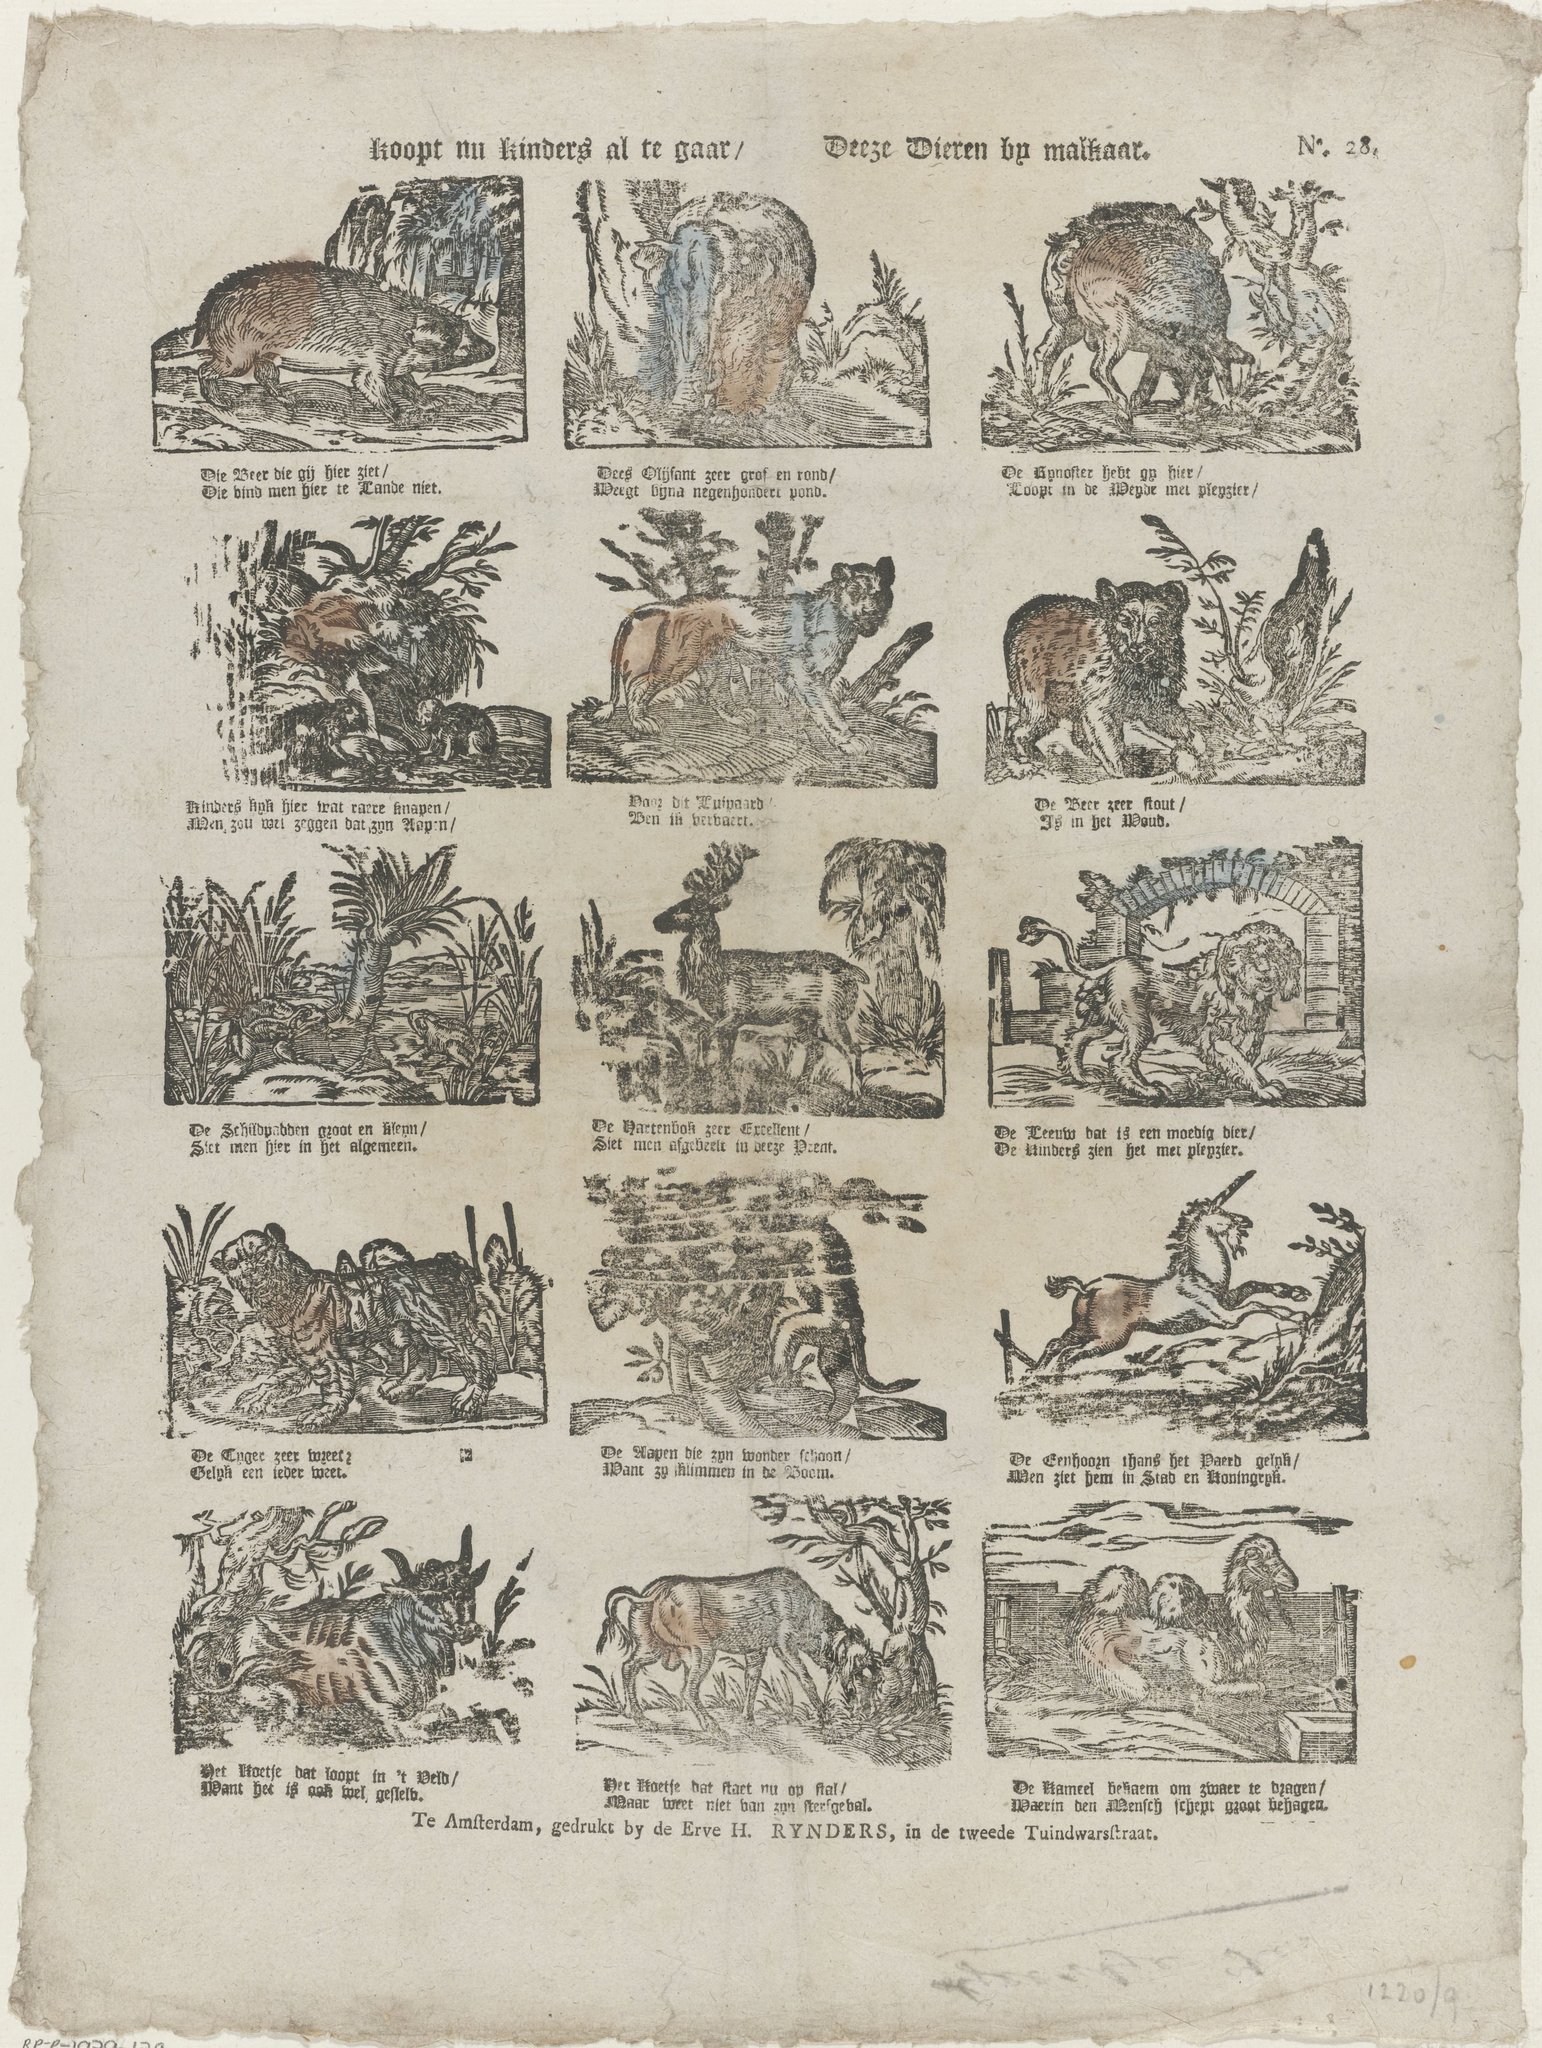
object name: print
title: Koopt nu kinders al te gaar / Deeze dieren by malkaar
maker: Anonymous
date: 1831-1854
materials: paper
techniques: colour, letterpress printing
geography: amsterdam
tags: beasts of prey, predatory animals: tiger, beasts of prey, predatory animals: leopard, unicorn, animals, beasts of prey, predatory animals: bear, beasts of prey, predatory animals: lion, trunked animals: elephant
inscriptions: collector's mark: Lugt 2228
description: Blad met 15 voorstellingen van dieren, zoals een olifant, een luipaard, een beer en een eenhoorn. Onder elke afbeelding een tweeregelig vers. Genummerd rechtsboven: No. 28.